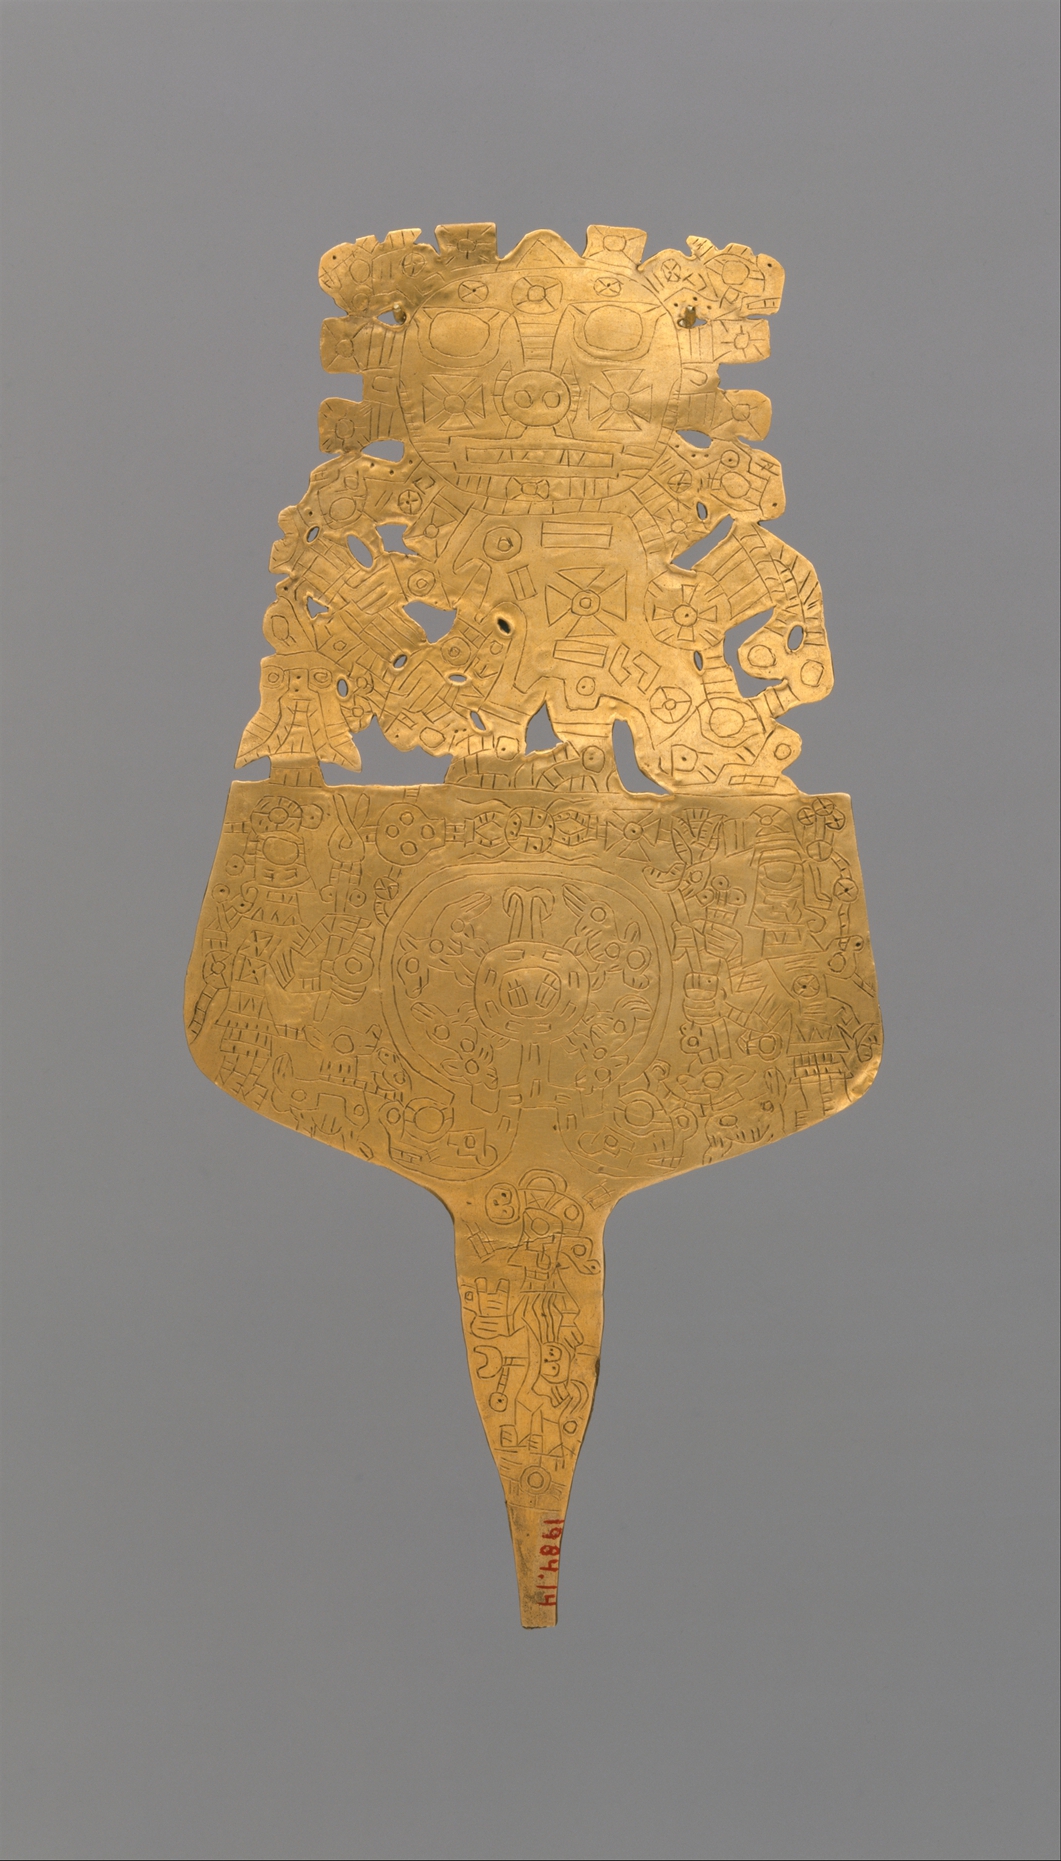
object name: ornament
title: Ornamental Plume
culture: pukara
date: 200 BCE-400 CE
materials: gold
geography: peru